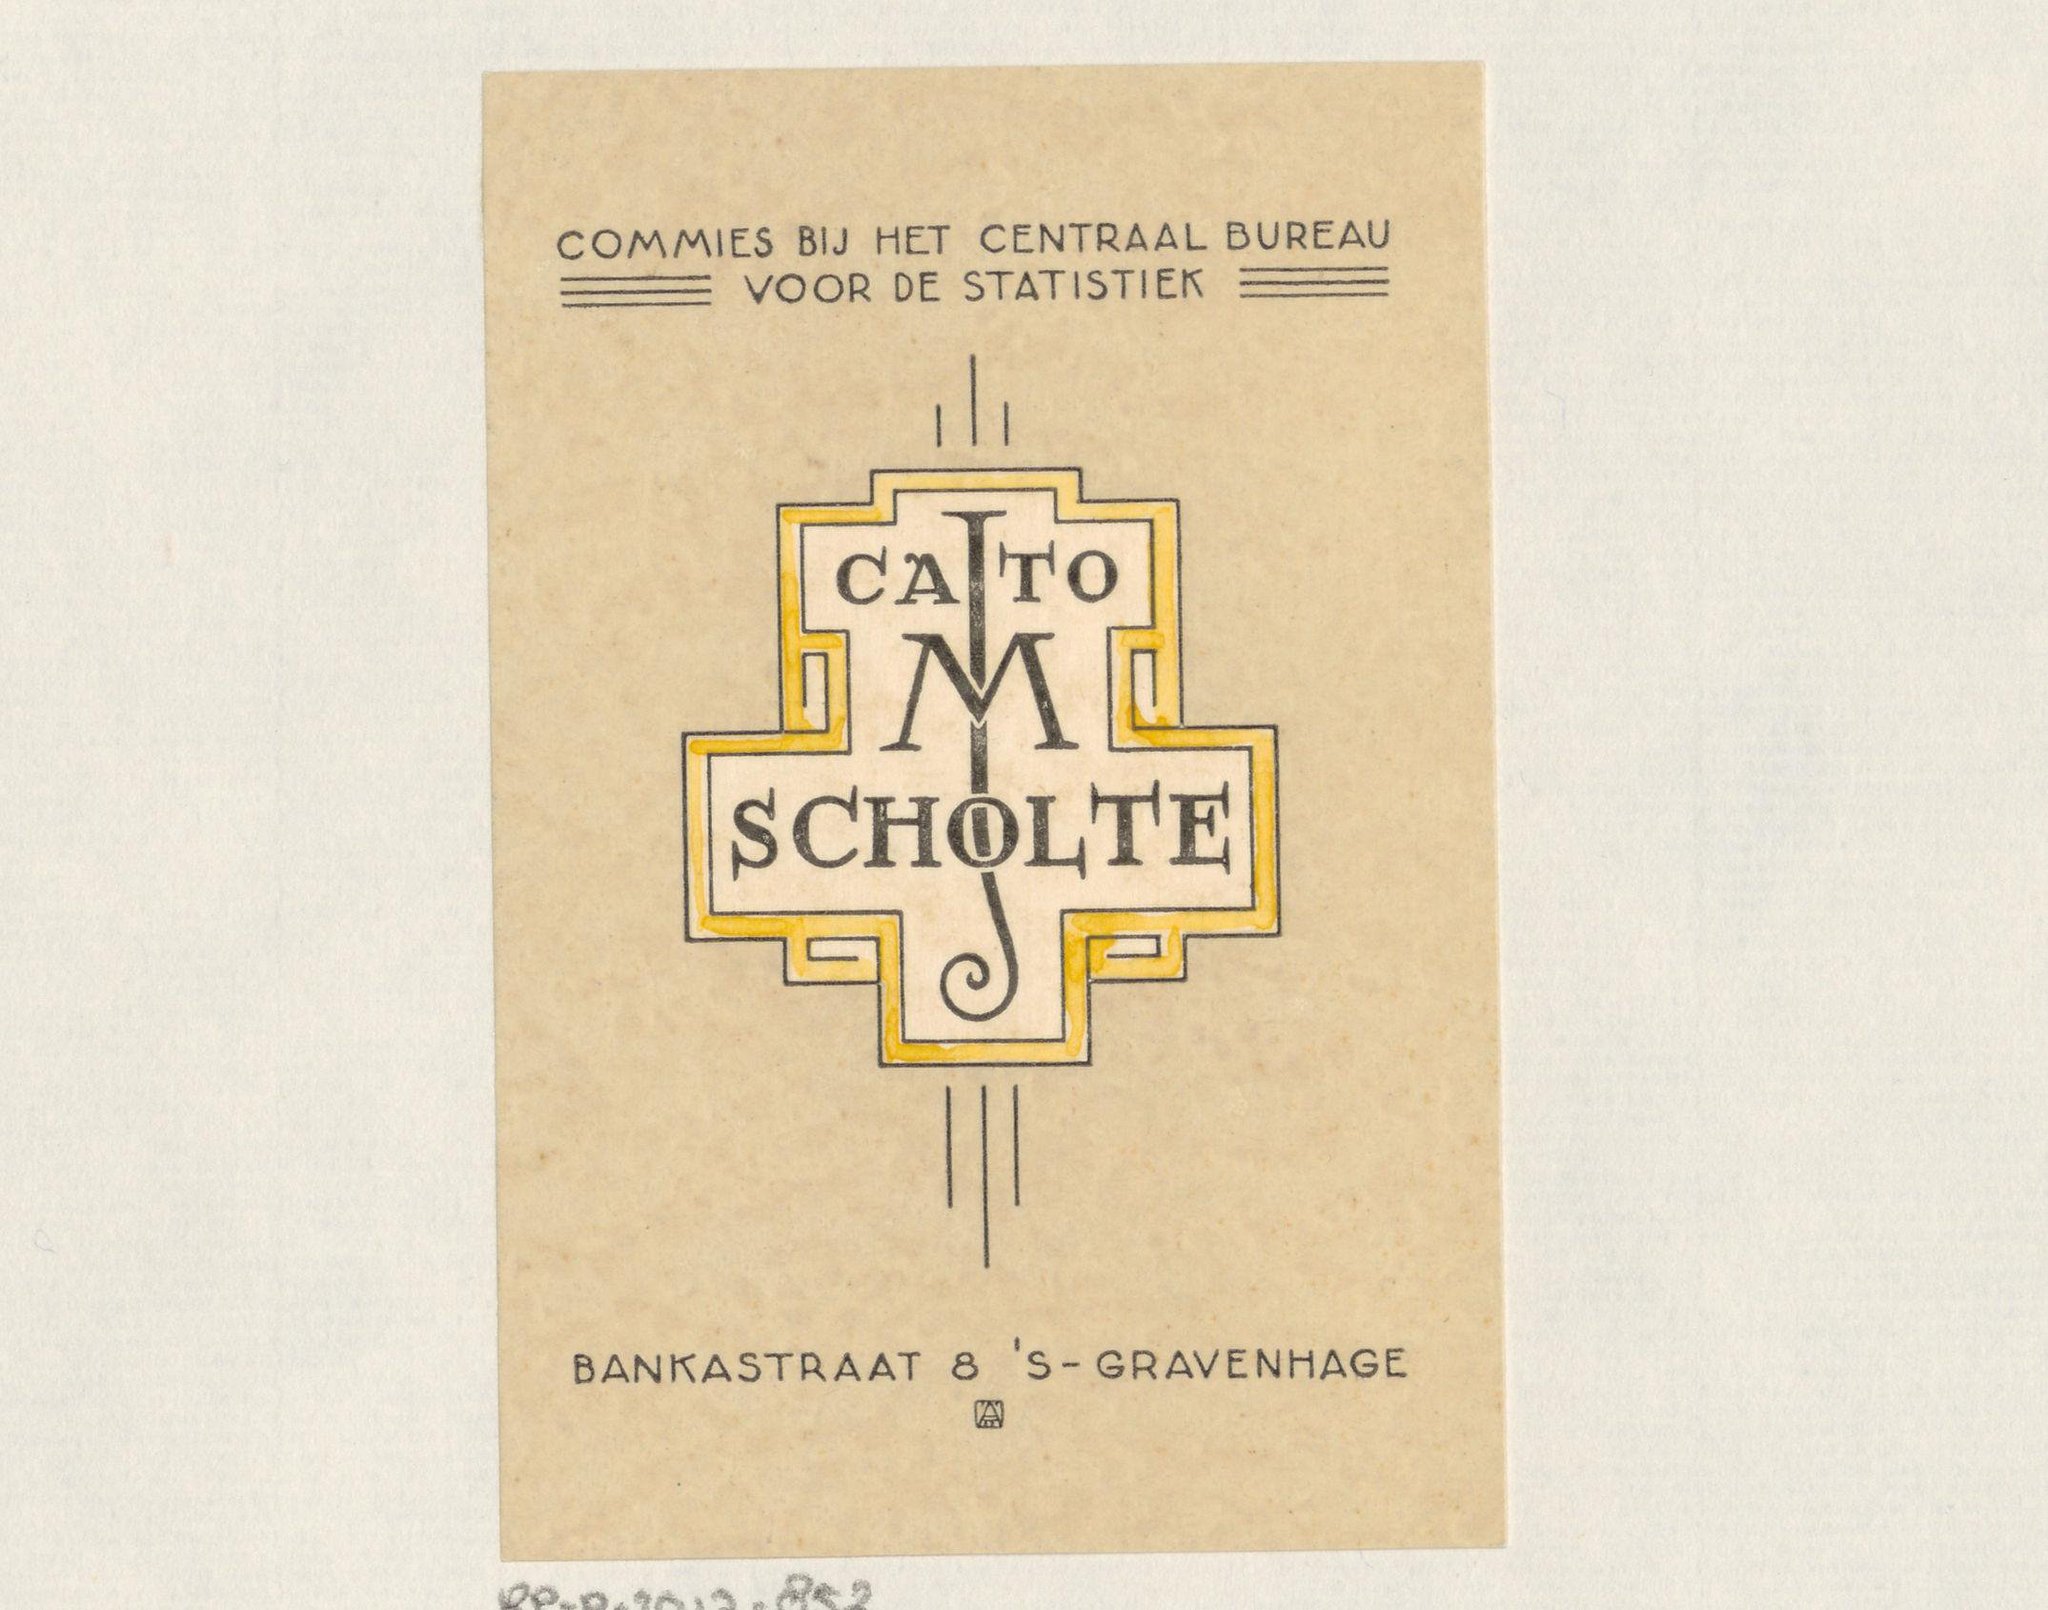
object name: bookplate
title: Ex libris van Cato J.M. Scholte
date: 1935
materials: paper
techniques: hand coloring, printing block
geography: netherlands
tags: cato j.m. scholte